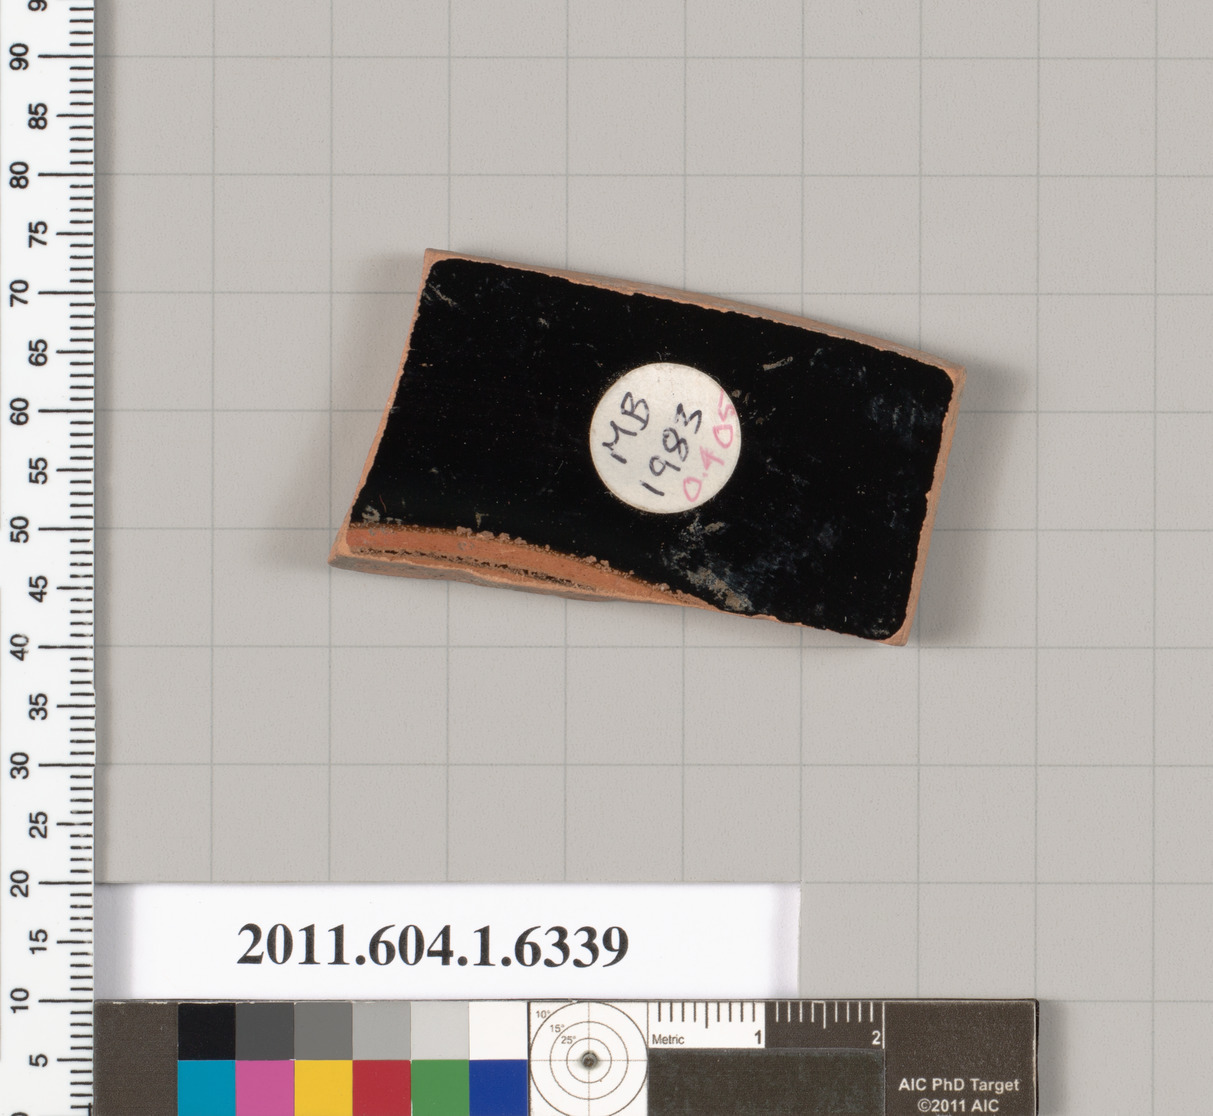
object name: kylix fragment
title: Terracotta fragment of a kylix (drinking cup)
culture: greek, attic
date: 500-480 BCE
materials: terracotta